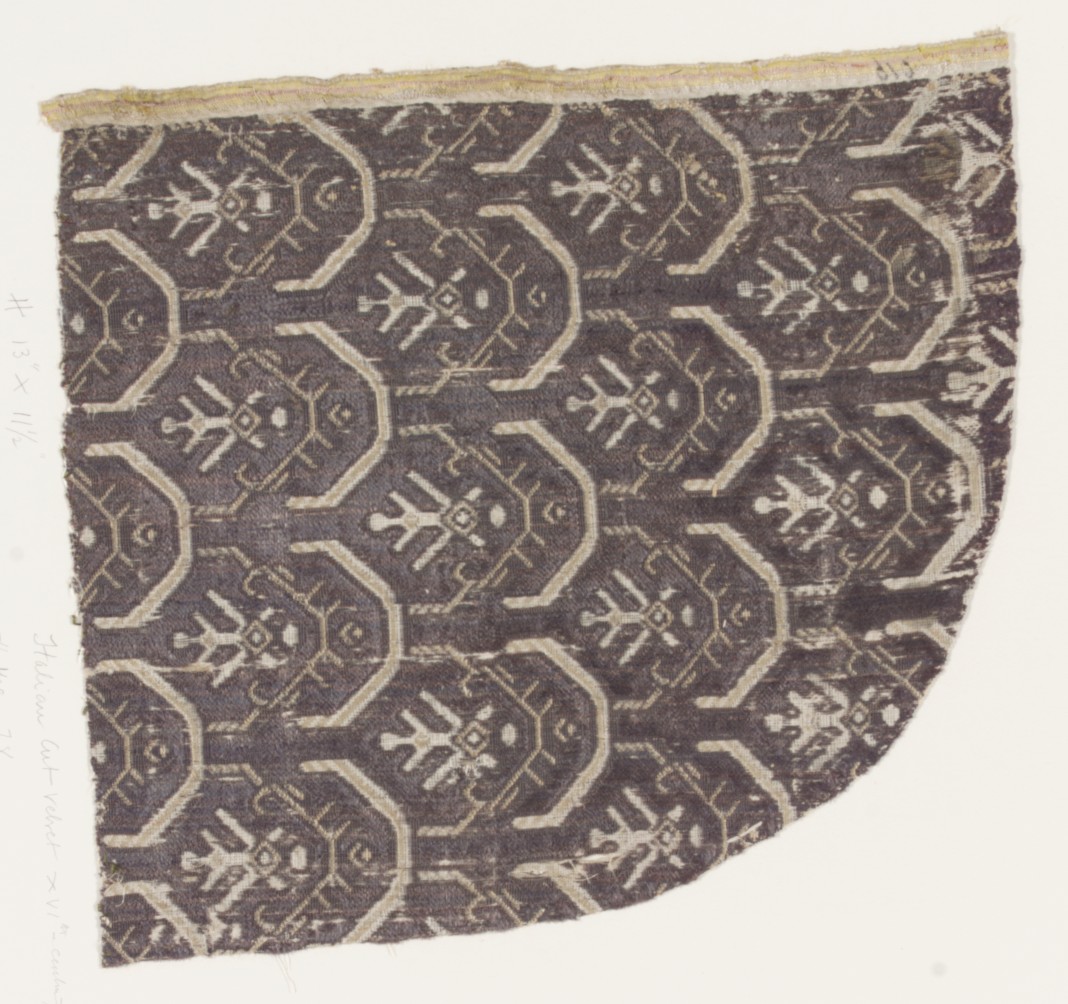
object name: fragment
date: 1501-1600